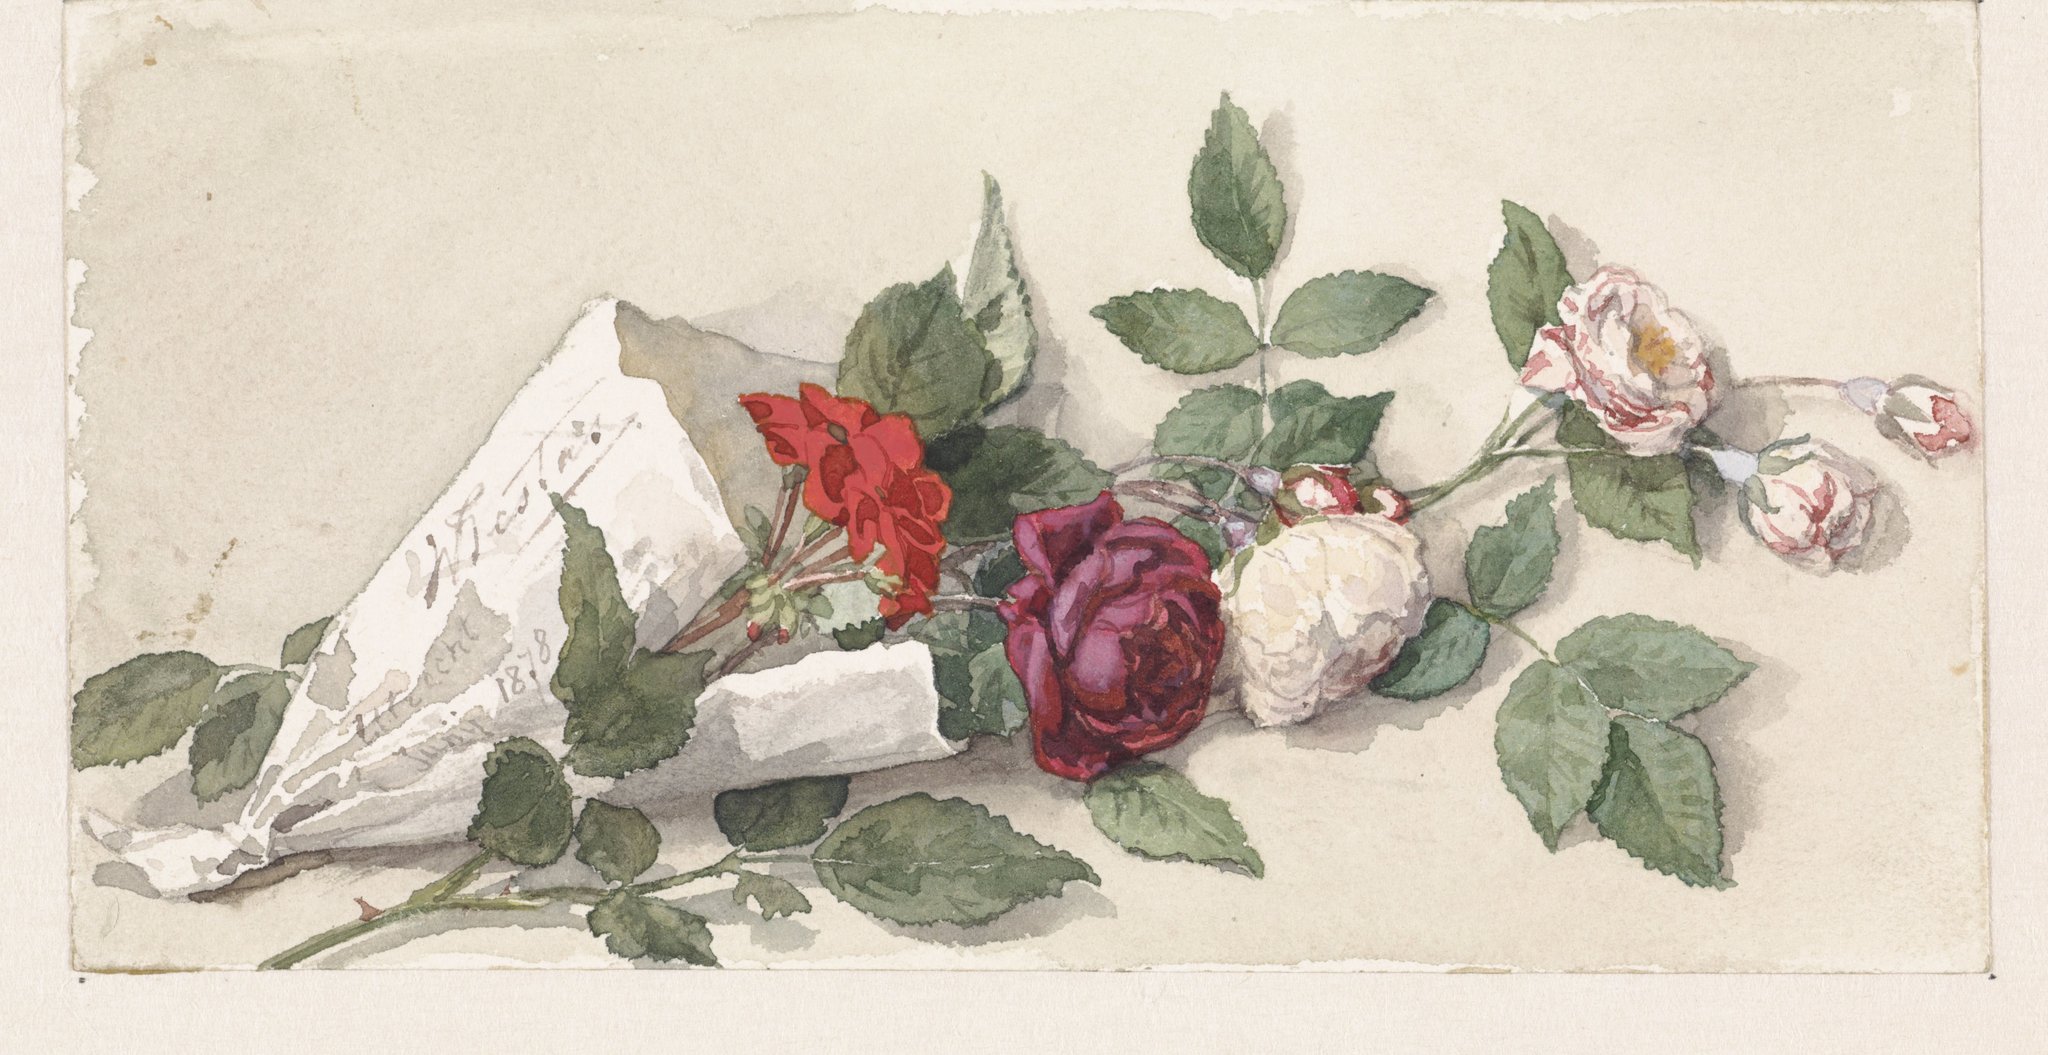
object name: watercolor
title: Boeket rozen en pelargonium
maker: willem de famars testas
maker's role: draughtsman, painter, print maker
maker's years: 1834-1896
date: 1806-1878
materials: paper, pencil, watercolor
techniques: brush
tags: cut flowers; nosegay, bunch of flowers, flowers: geranium, flowers: rose